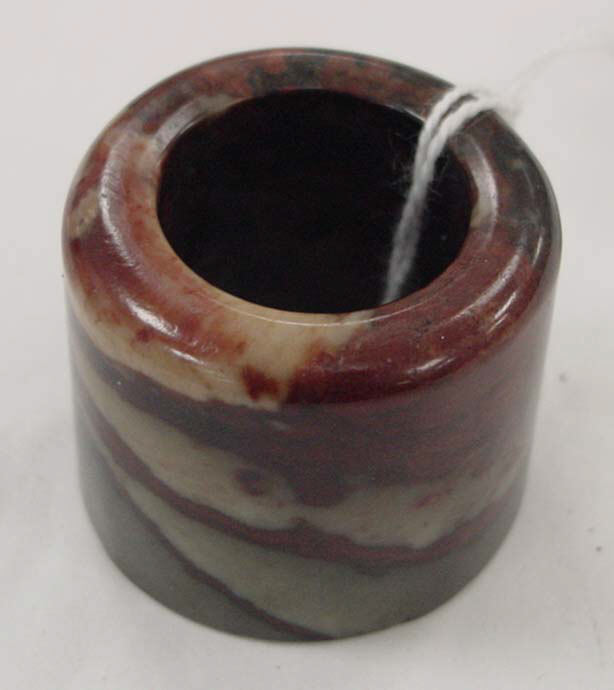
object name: ring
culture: chinese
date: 1801-1900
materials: jade